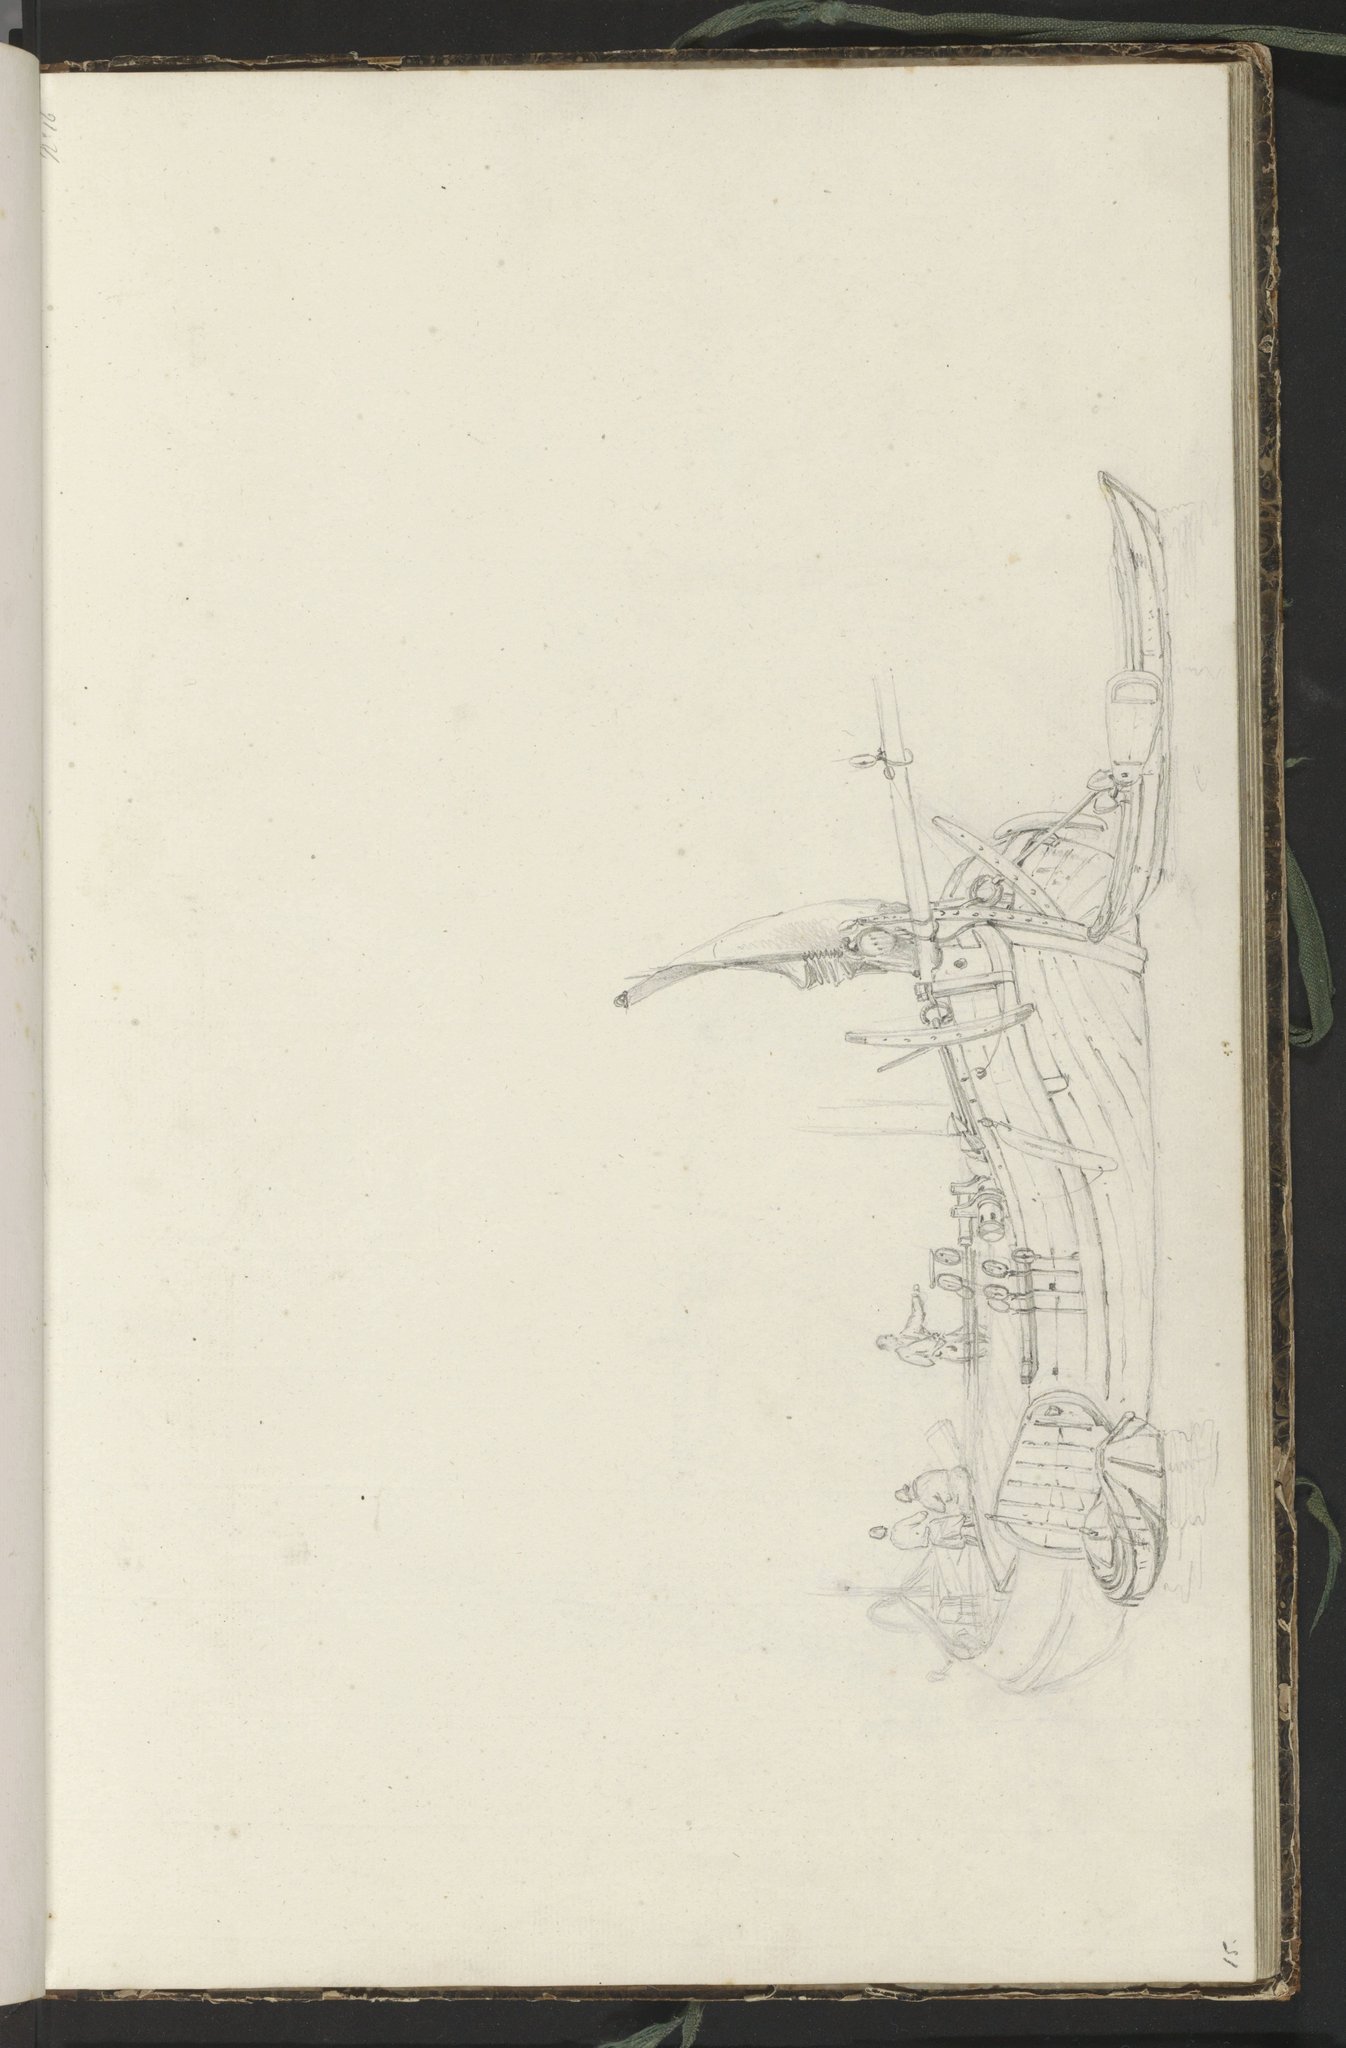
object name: sketchbook leaf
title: Drie mannen op een vissersboot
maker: johannes christiaan schotel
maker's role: draughtsman, painter, print maker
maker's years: 1787-1838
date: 1797-1838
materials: paper, pencil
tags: crew ~ ship, sailing-ship, sailing-boat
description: Blad 15 recto uit een schetsboek met 44 bladen.